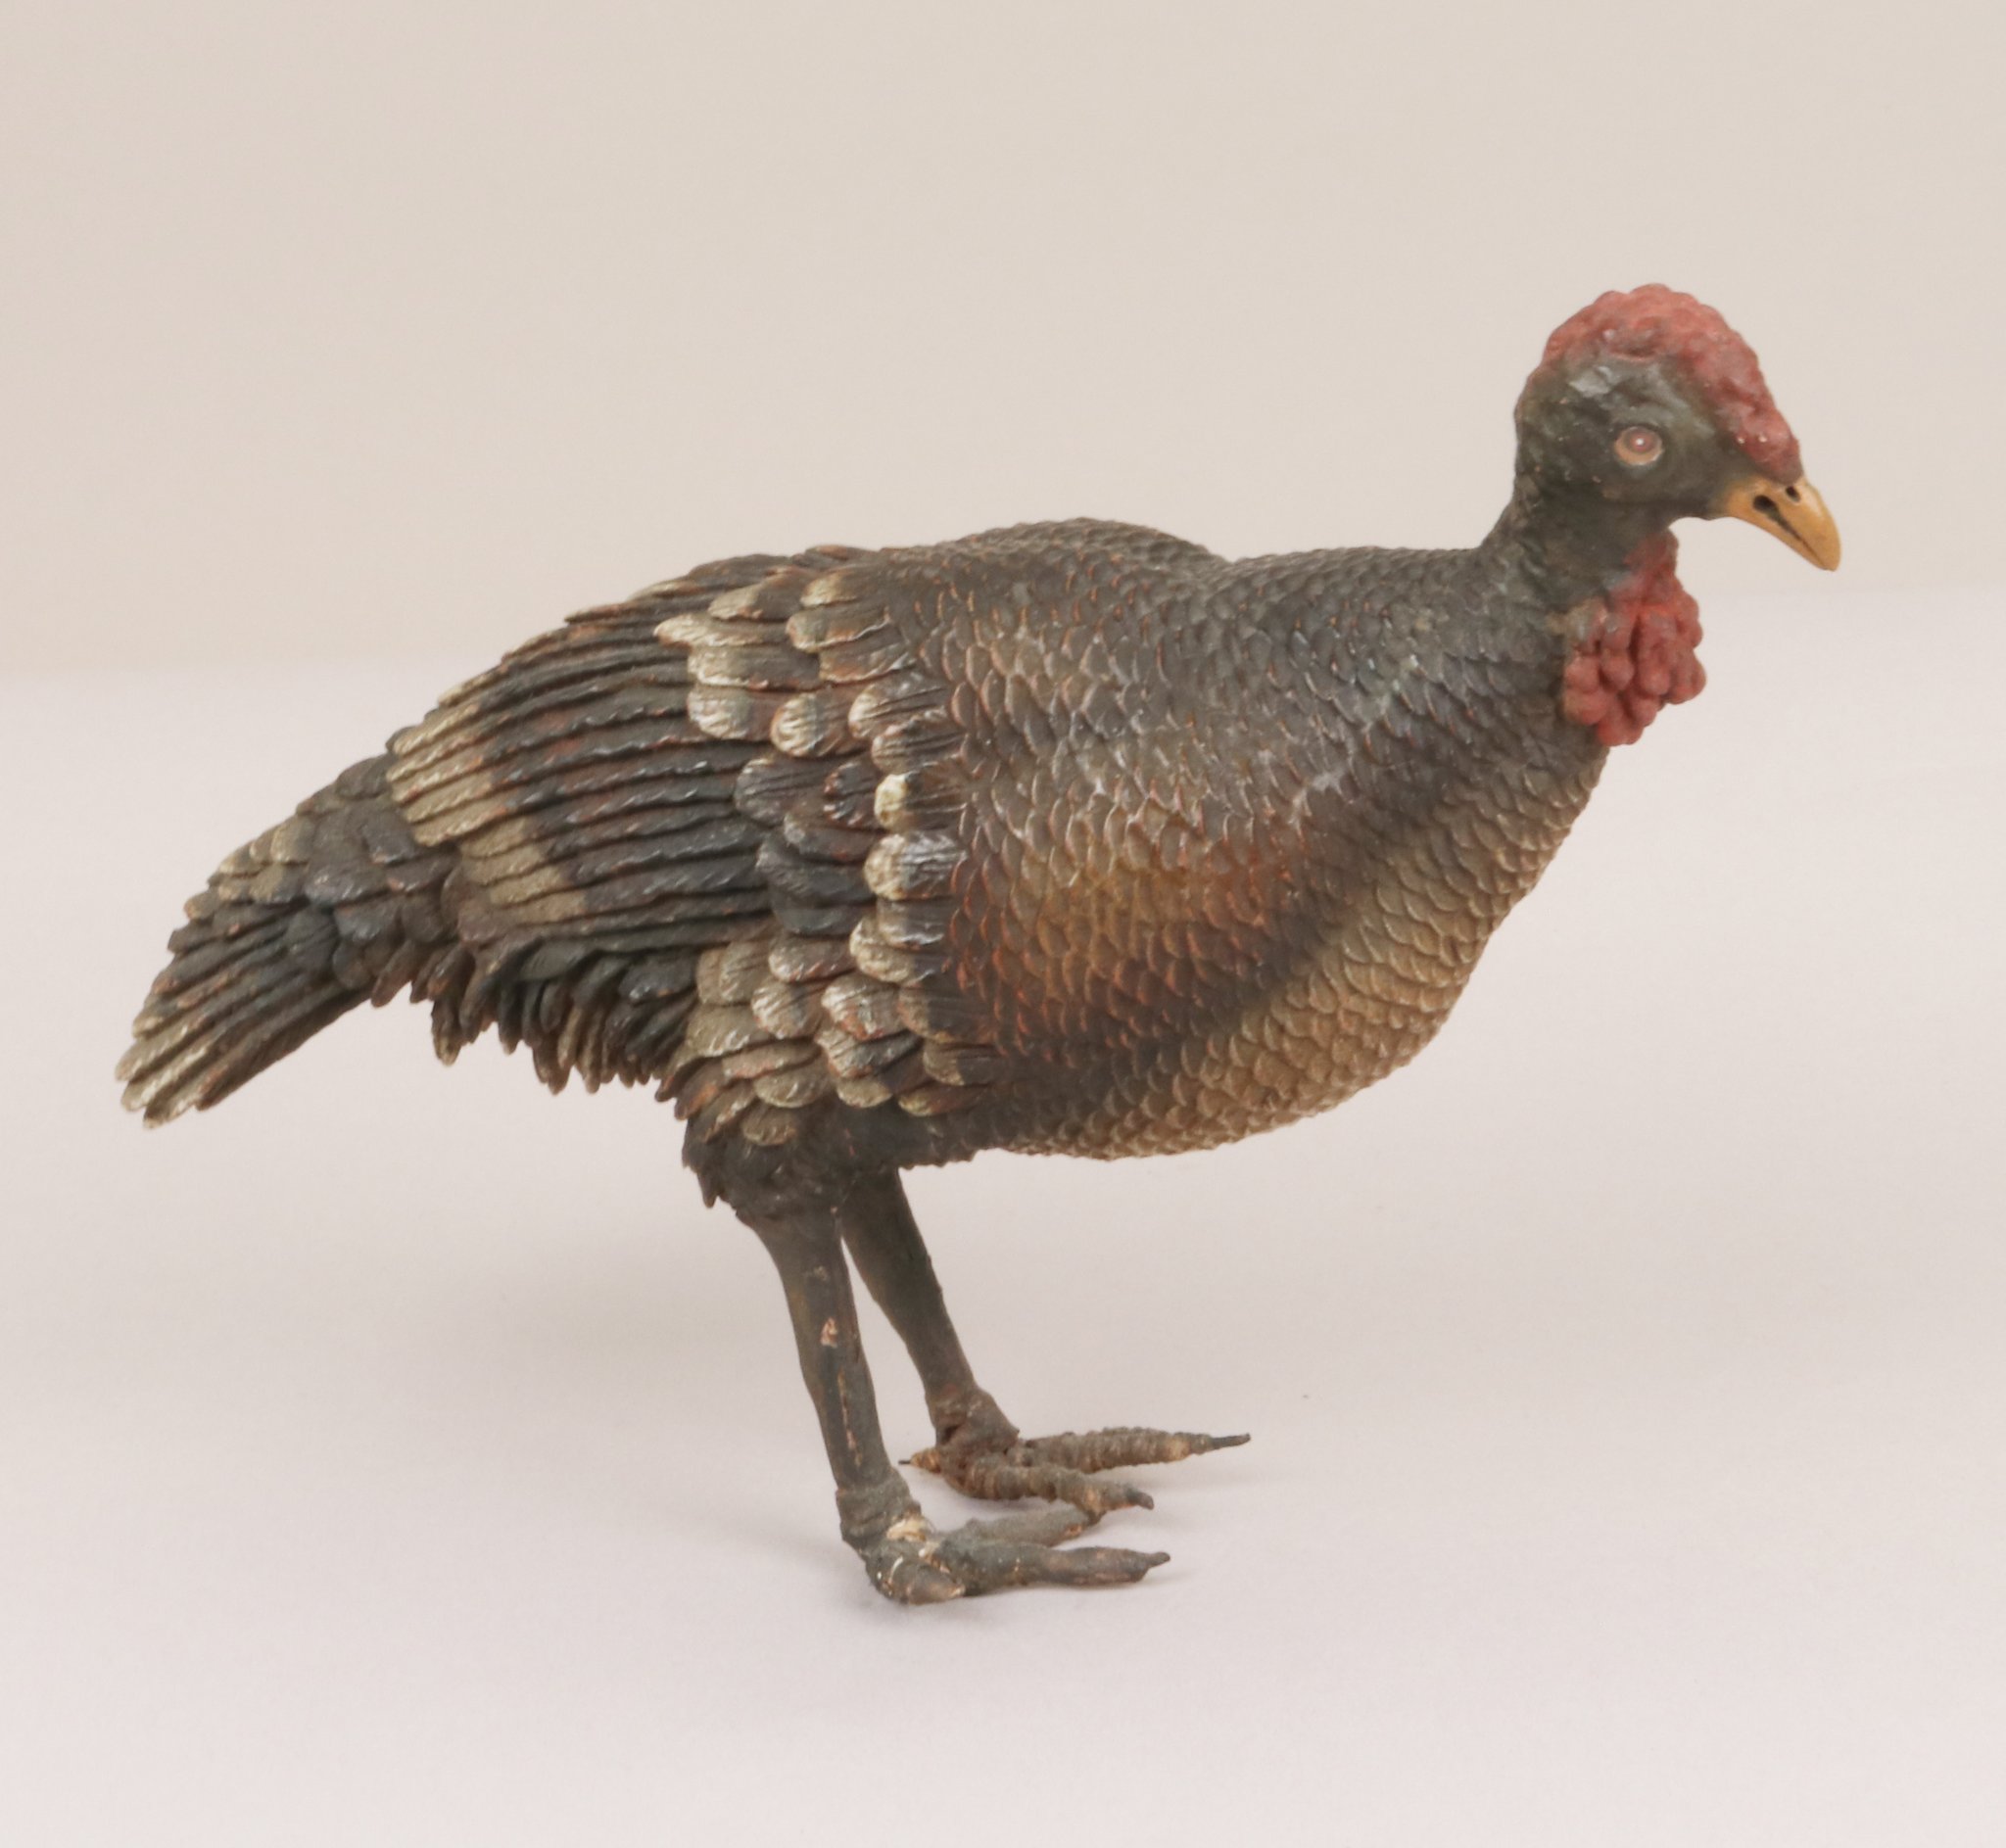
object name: crèche figure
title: Fowl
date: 1701-1800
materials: terracotta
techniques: polychrome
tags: birds